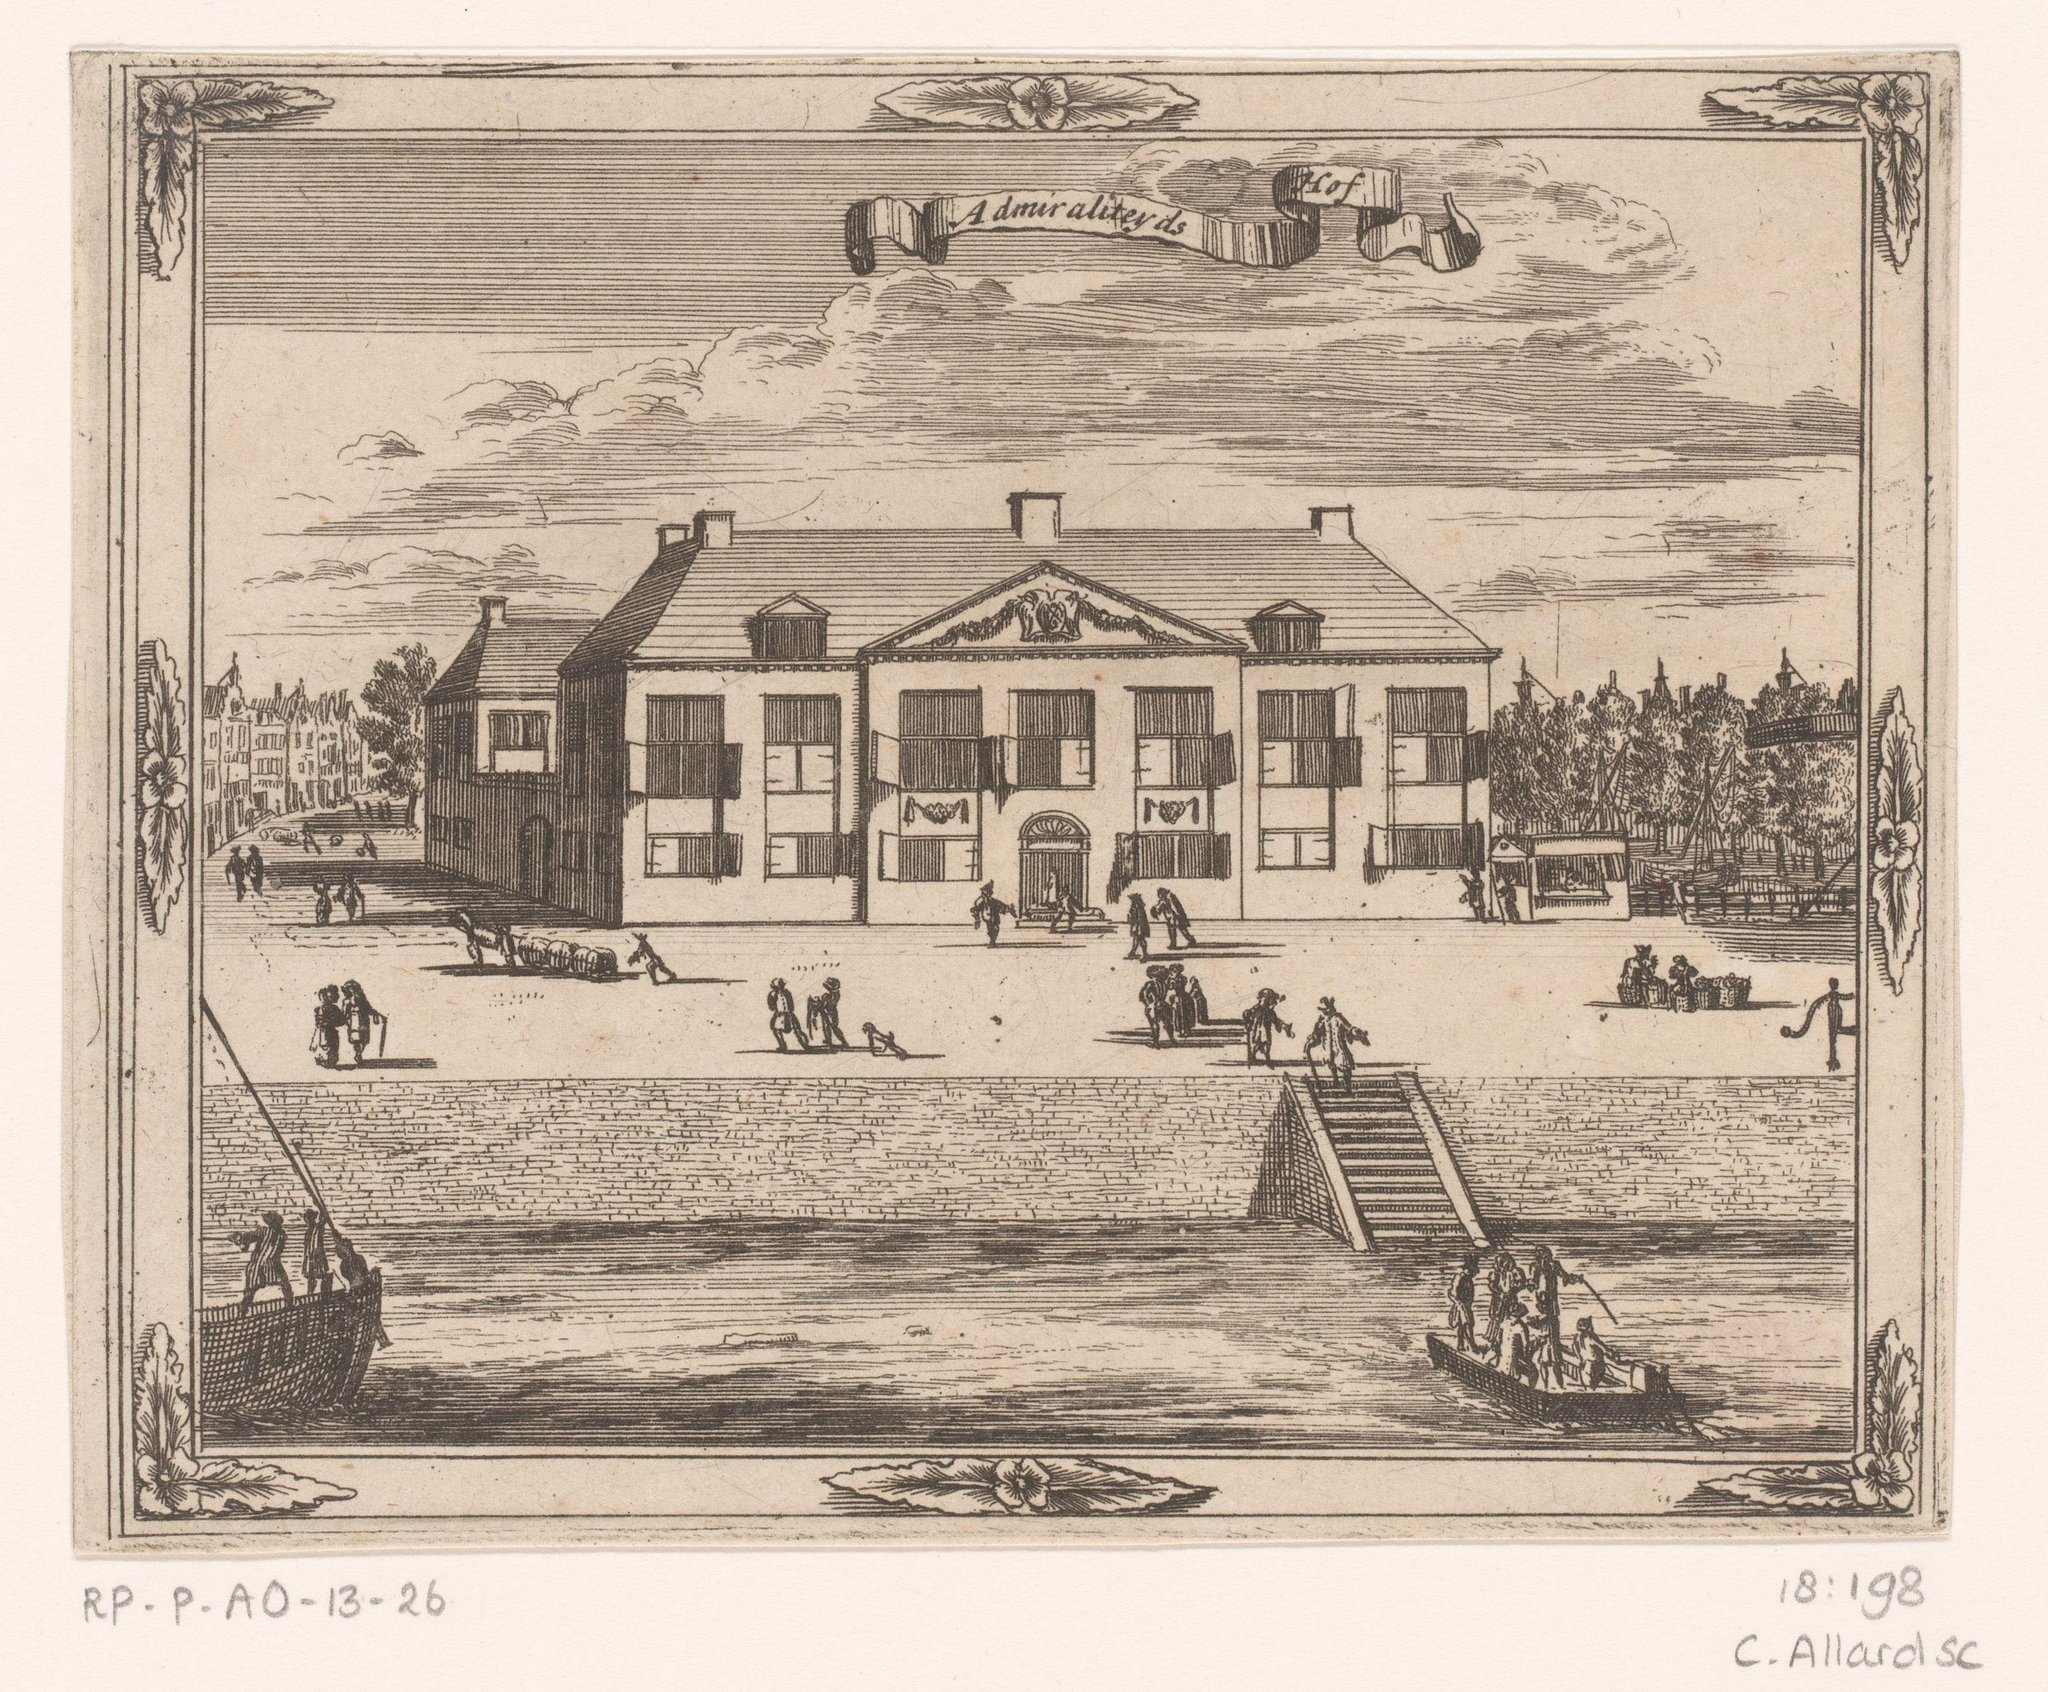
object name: print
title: Admiraliteyds Hof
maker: jacobus harrewijn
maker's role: print maker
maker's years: 1660-1740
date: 1715-1730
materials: paper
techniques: etching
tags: exterior ~ representation of a building, canals, waters (in city) (+ city(-scape) with figures, staffage), street (+ city(-scape) with figures, staffage)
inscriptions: collector's mark: Lugt 195, collector's mark: Lugt 2228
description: Prent vermoedelijk eerst met dertien andere stadsgezichten uitgegeven als onderdeel van de sierrand van – in ieder geval de derde staat en mogelijk ook de tweede van – de plattegrond 'Tabula Roterodami Novissima' (zie RP-P-AO-13-11). Later nog een keer als onderdeel van een prentserie uitgegeven: Les principaux edifices et vues de la ville de Rotterdam. Le tout fidèlement dessiné sur les lieux. Leiden: Pieter van der Aa, s.a. [adres 'dans l'Academie', dus 1715-1730]. De platen zijn voor zover na te gaan ongewijzigd gebleven.